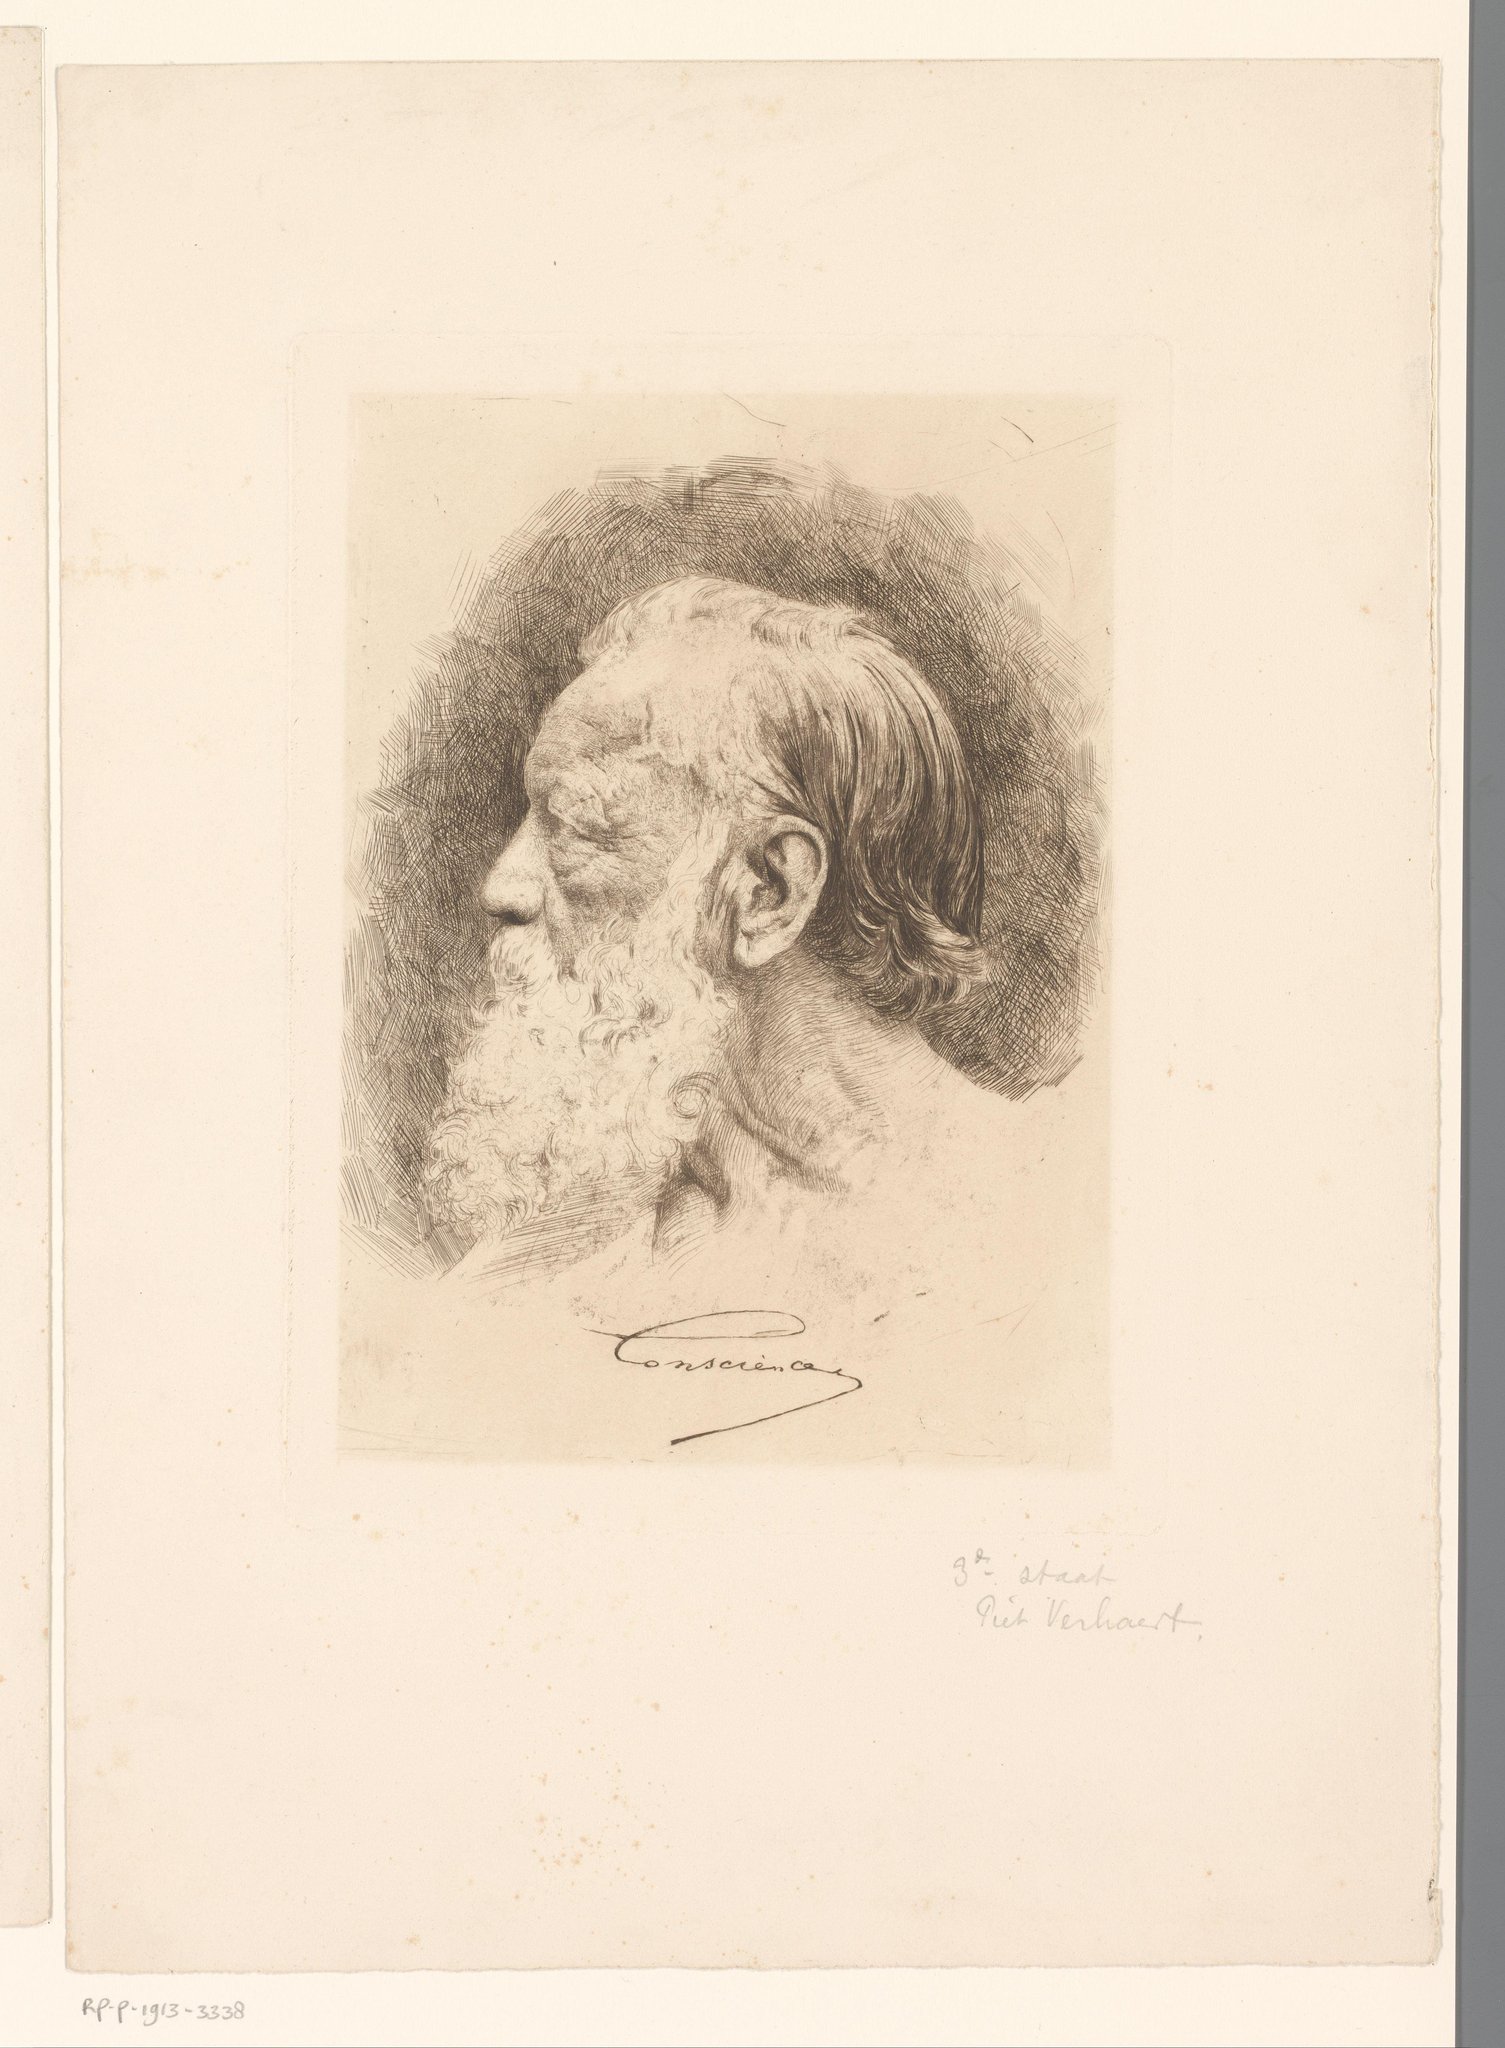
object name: print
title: Conscience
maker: piet verhaert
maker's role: print maker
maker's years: 1852-1908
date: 1883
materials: paper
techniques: etching, intaglio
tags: antwerp, historical persons, old man, beard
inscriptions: inscription: ‘3e staat’, collector's mark: Lugt 2228